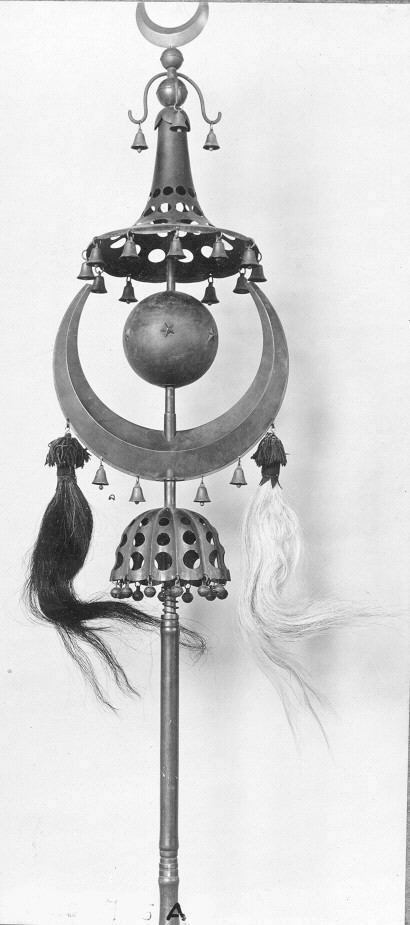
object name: schellenbaum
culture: german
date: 1801-1833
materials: metal, wood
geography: germany